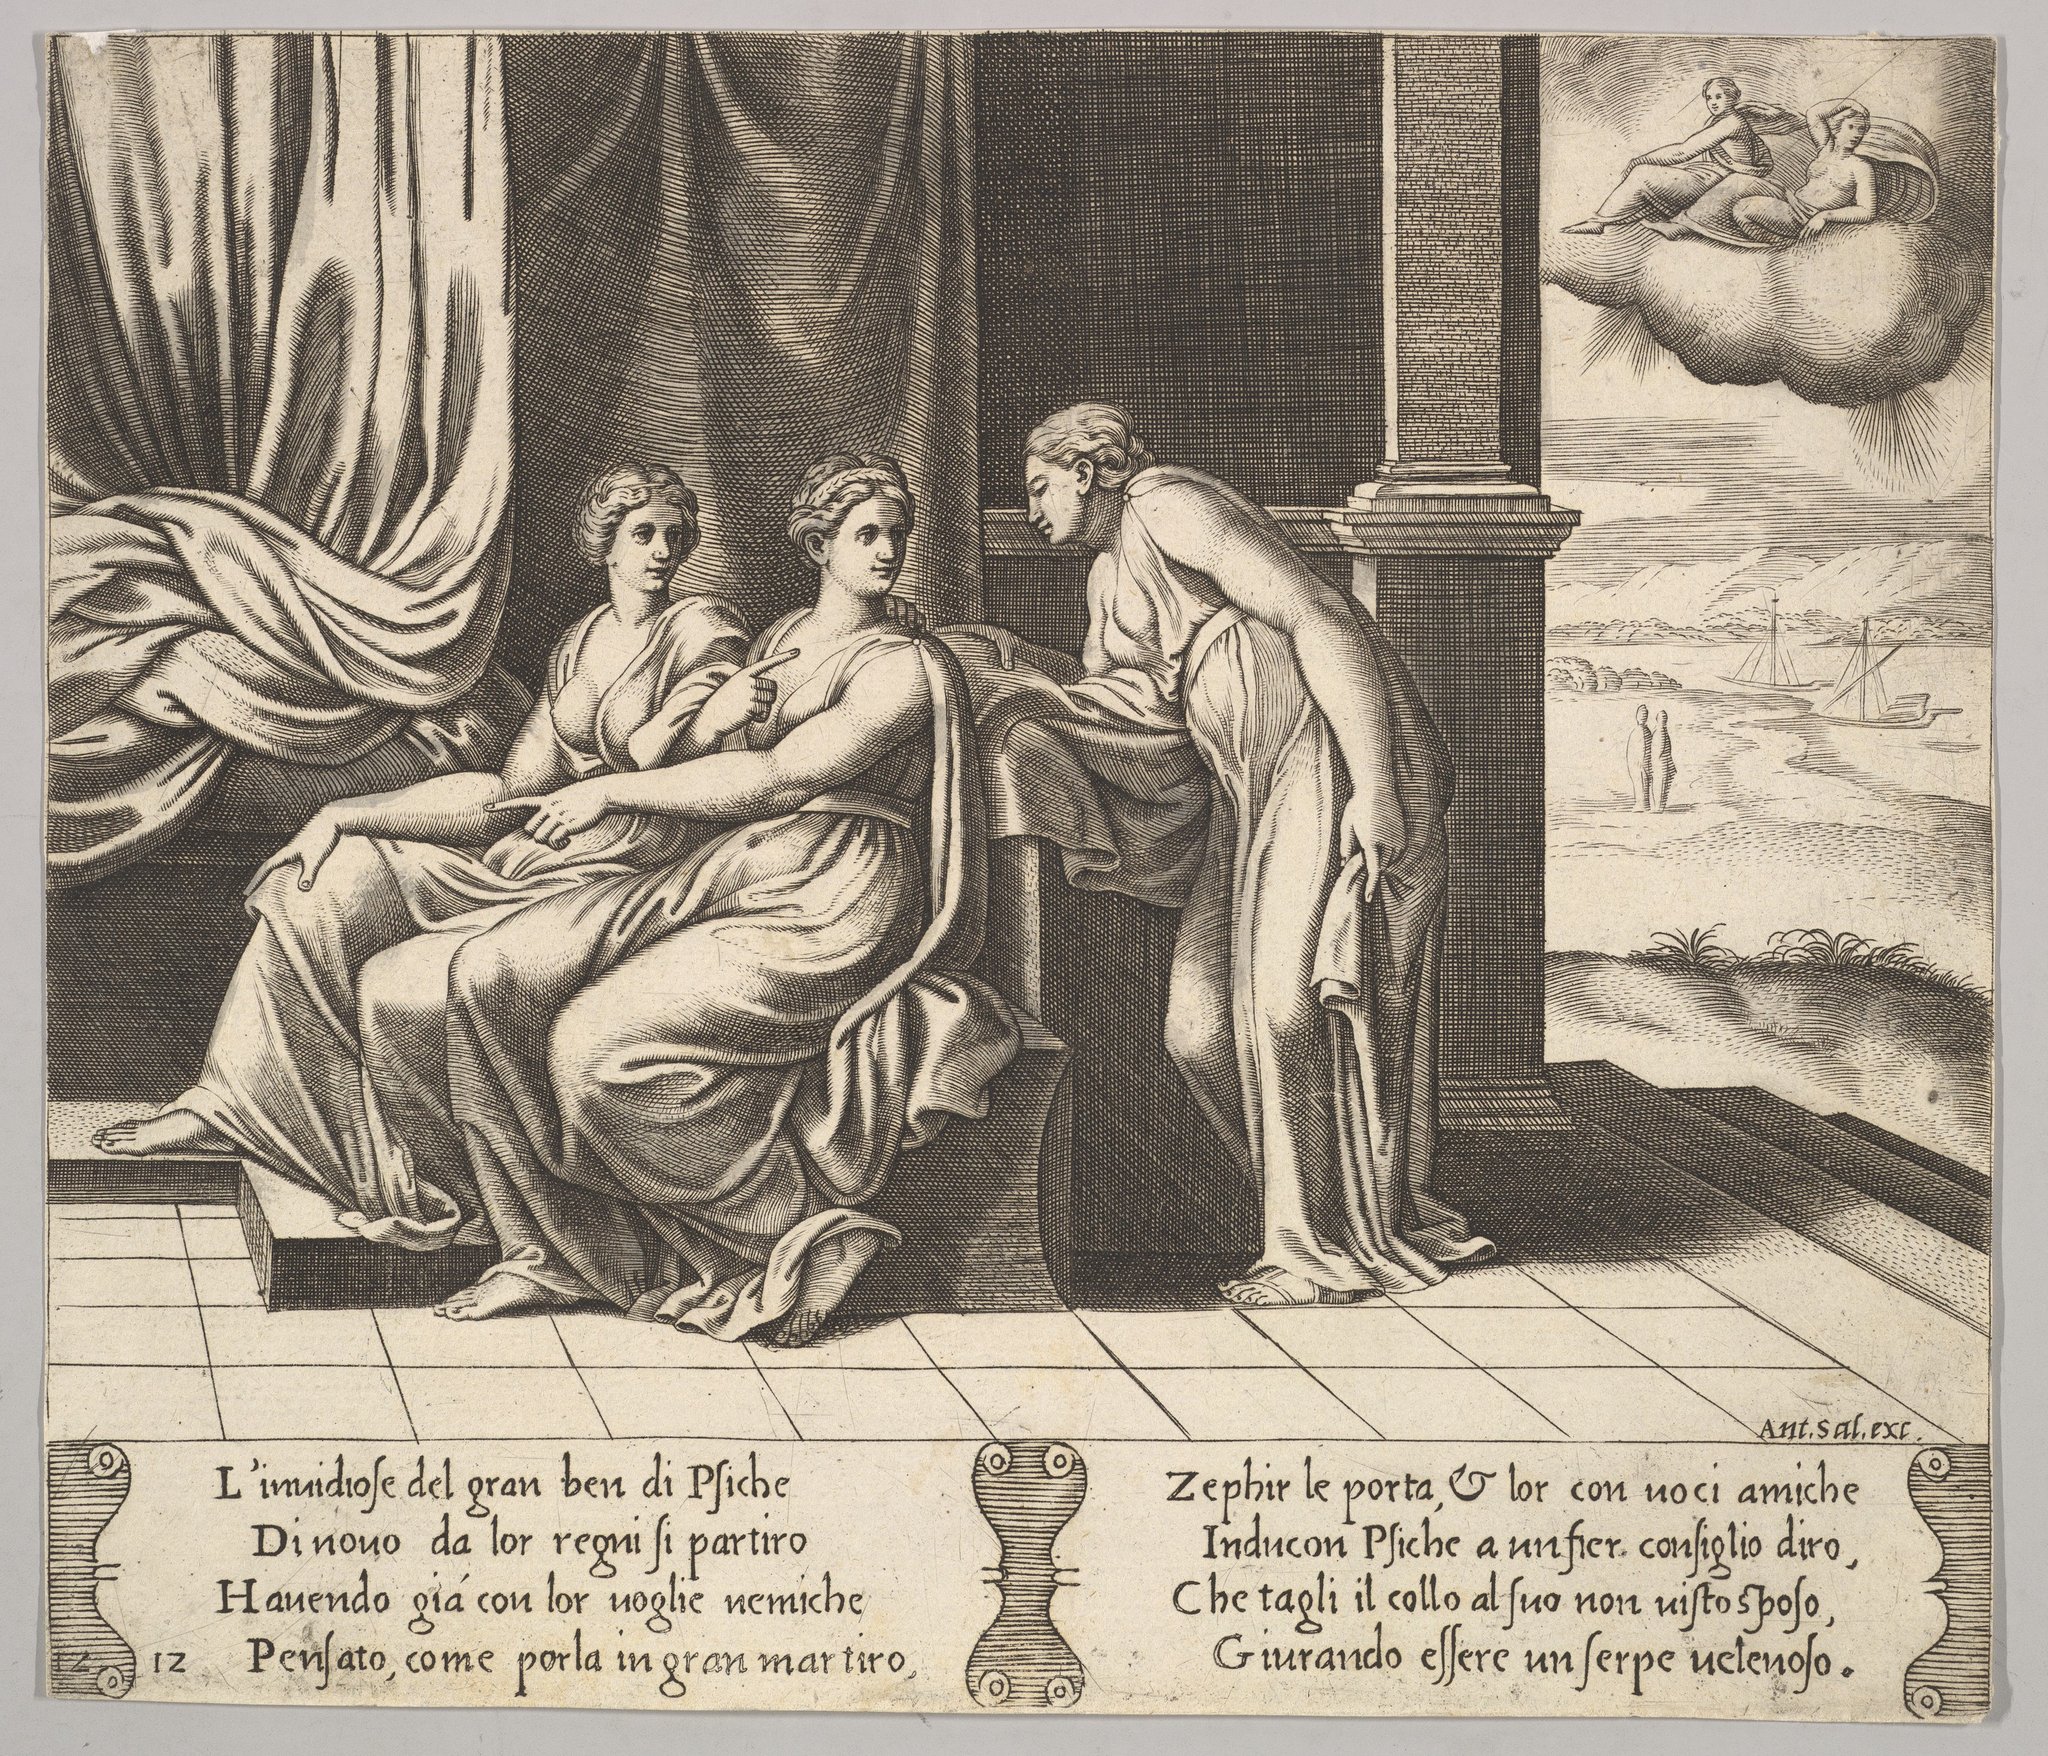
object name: print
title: Plate 12: Psyche's sisters persuade her a serpent is sleeping with her, from "The Fable of Cupid and Psyche"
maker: master of the die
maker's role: artist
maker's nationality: italian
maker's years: 1525-1560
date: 1530-1560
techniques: engraving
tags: women,psyche